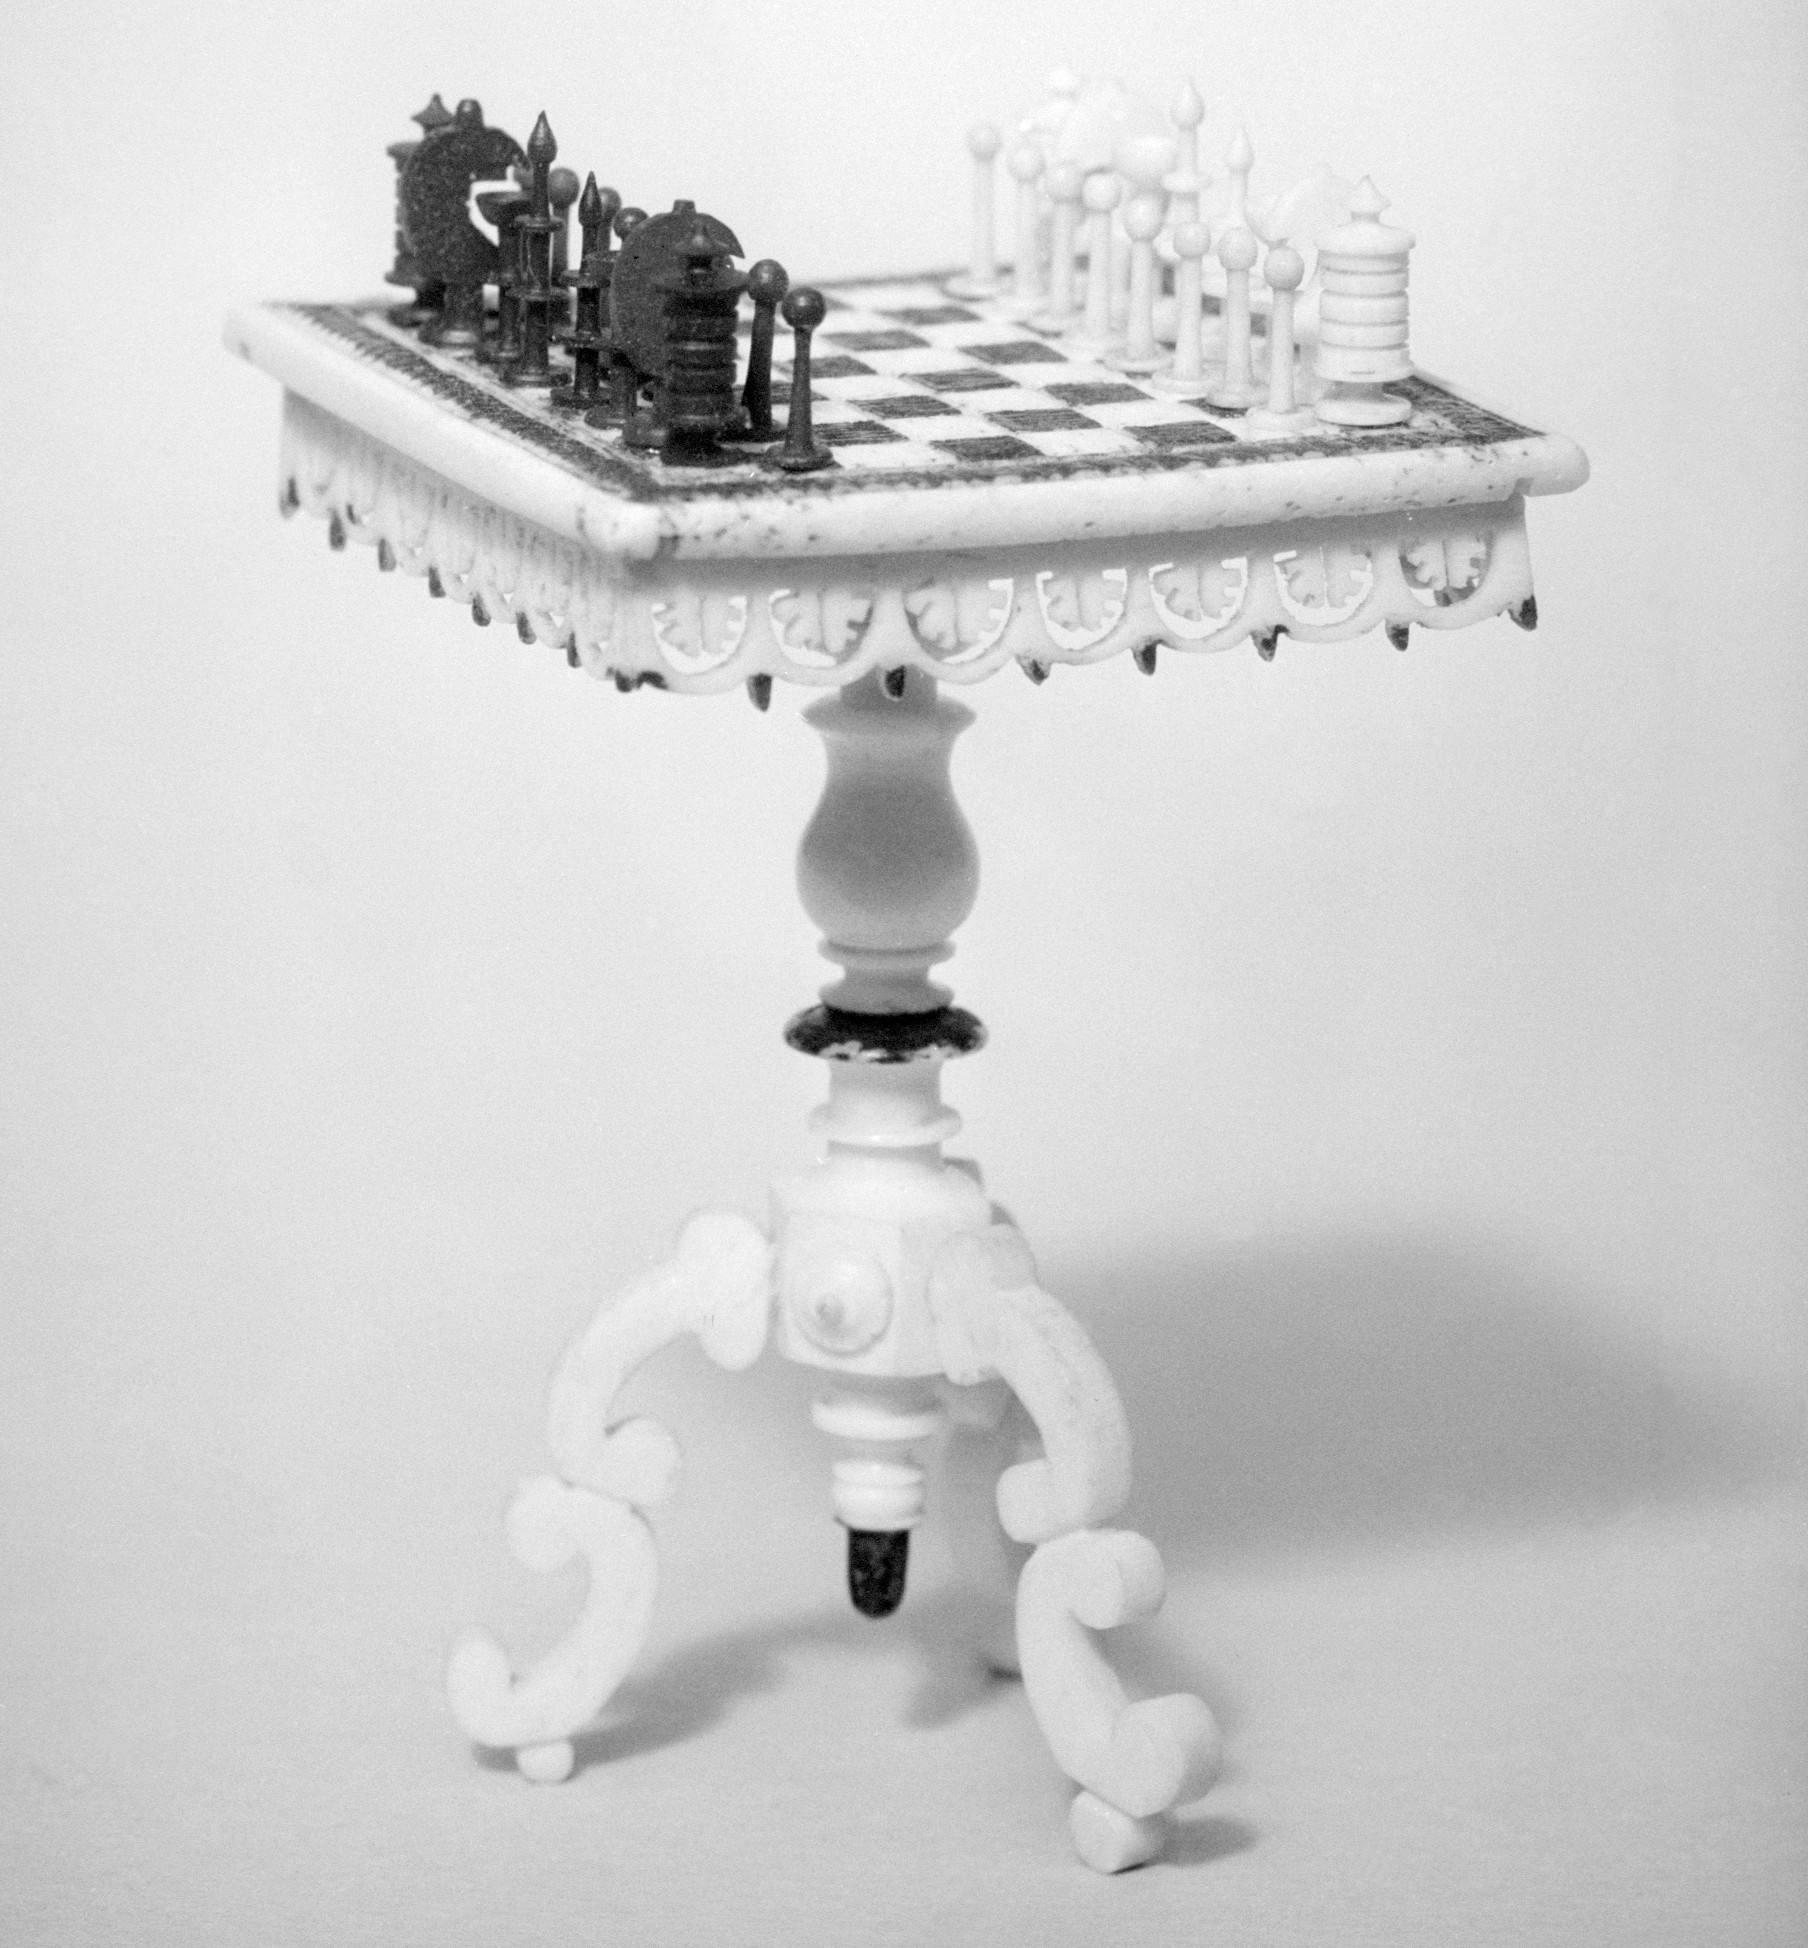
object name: chess set and table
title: Miniature chess set and table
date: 1801-1900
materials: bone